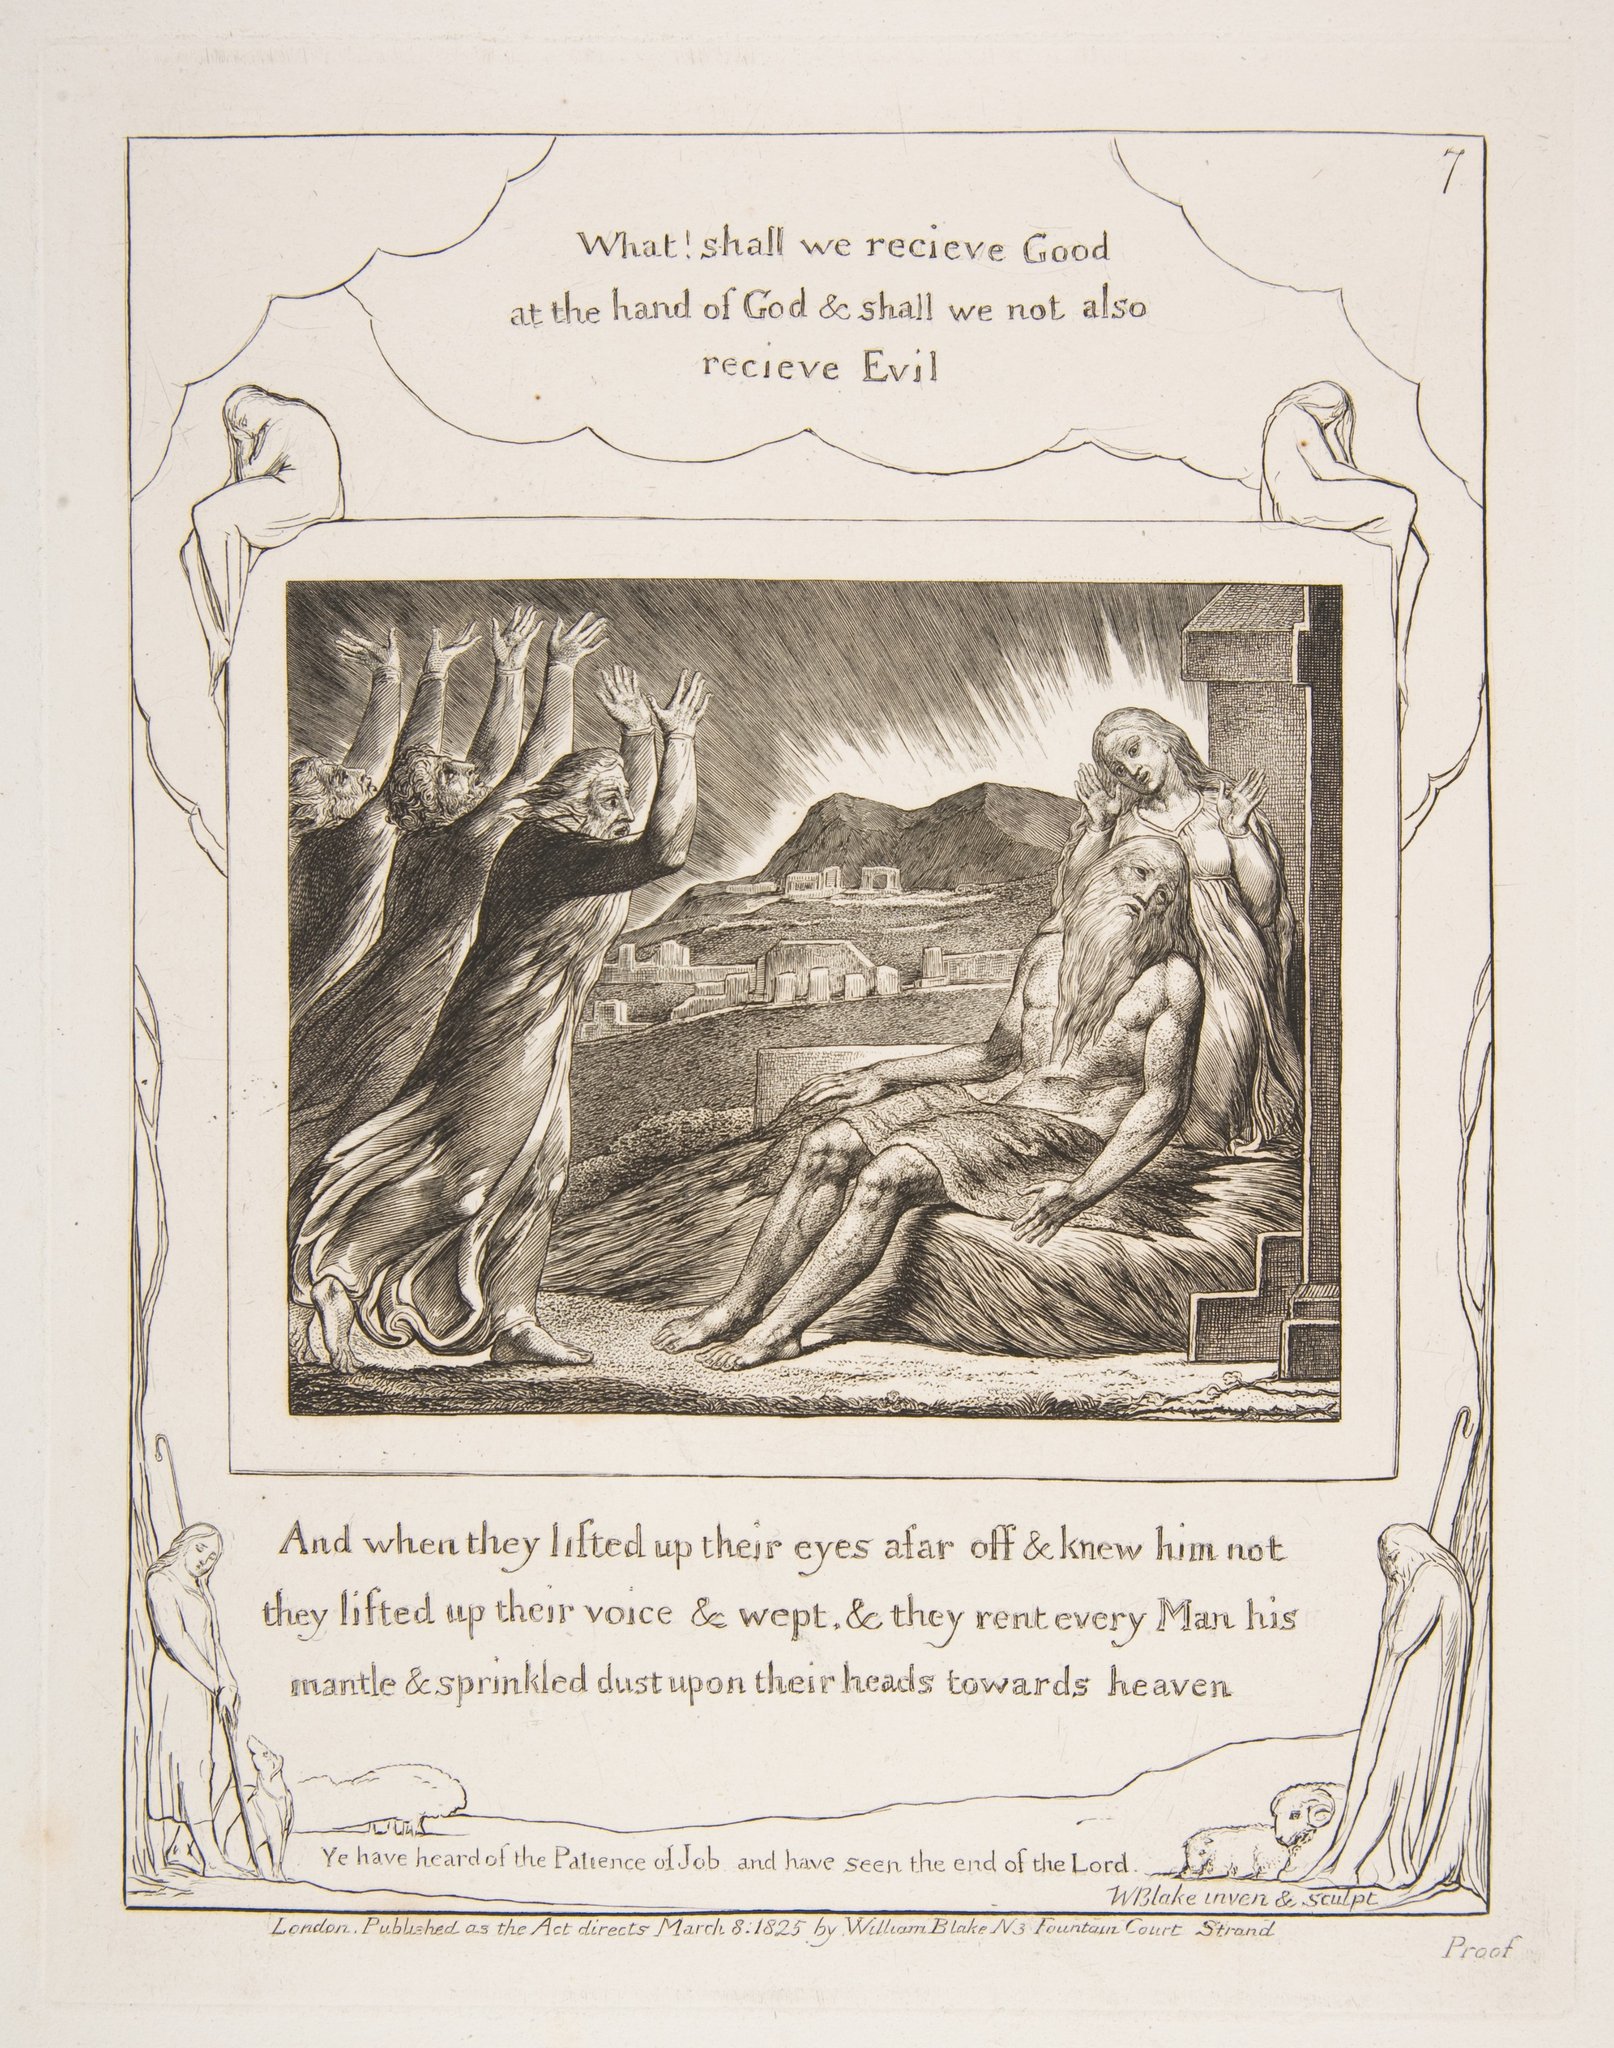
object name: print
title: Job's Comforters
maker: william blake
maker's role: artist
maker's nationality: british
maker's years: 1757-1827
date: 1825-1826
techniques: engraving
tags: men,women,job